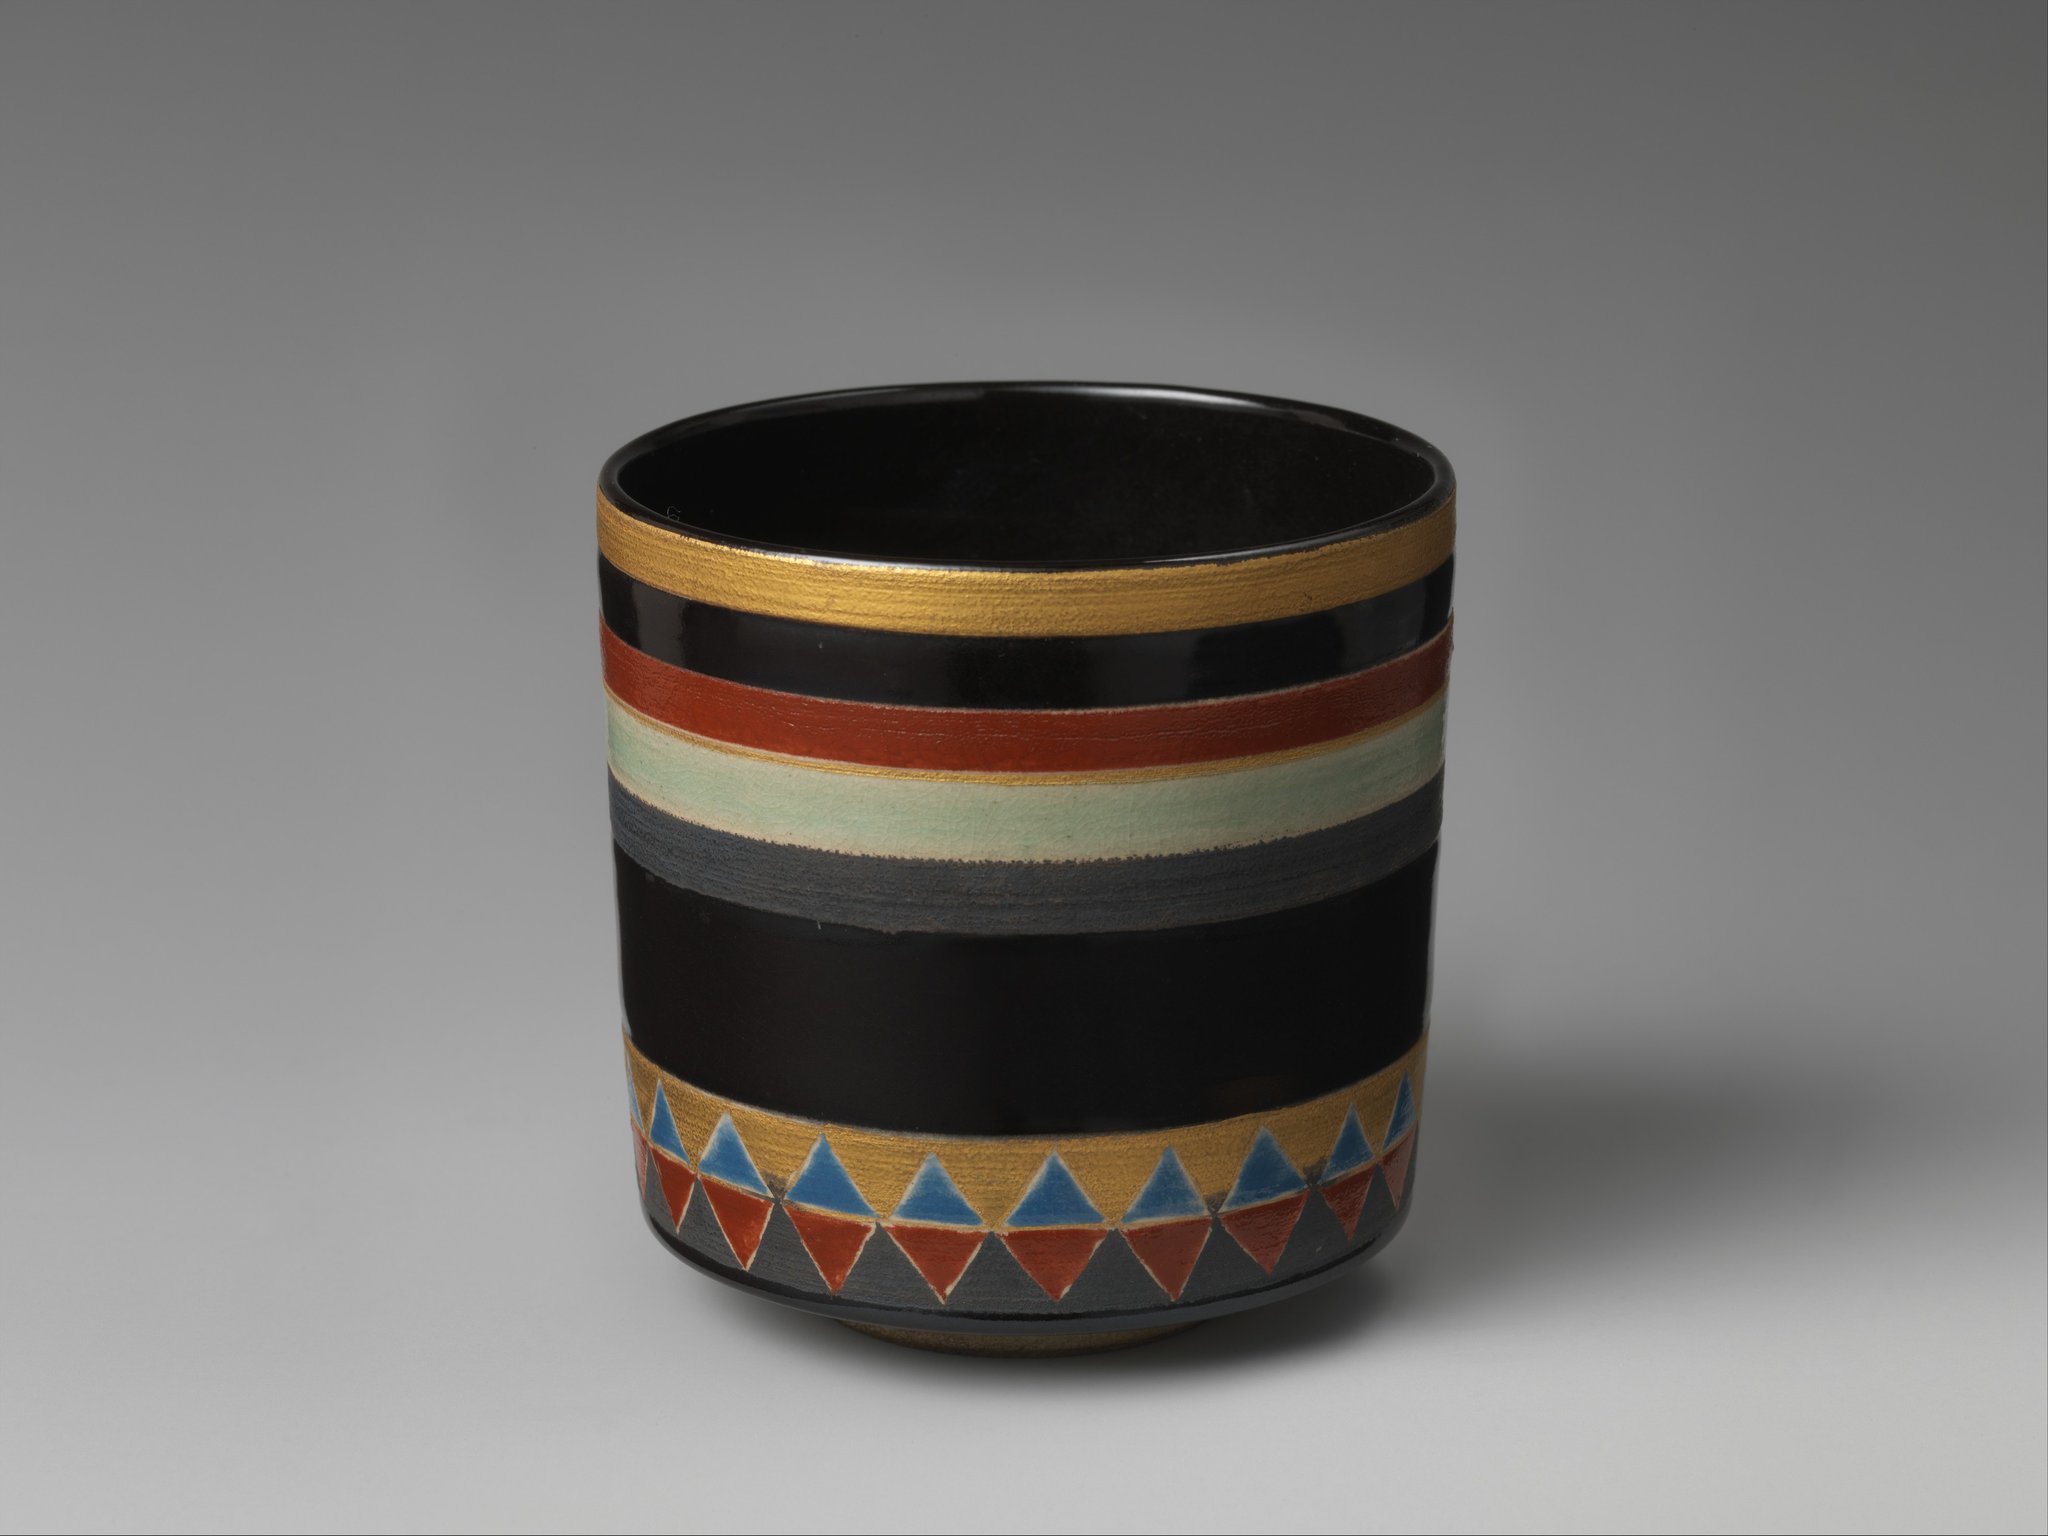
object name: cup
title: Ninsei-style Serving Container (Mukōzuke)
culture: japanese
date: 1801-1900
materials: enamel, stoneware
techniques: overglaze